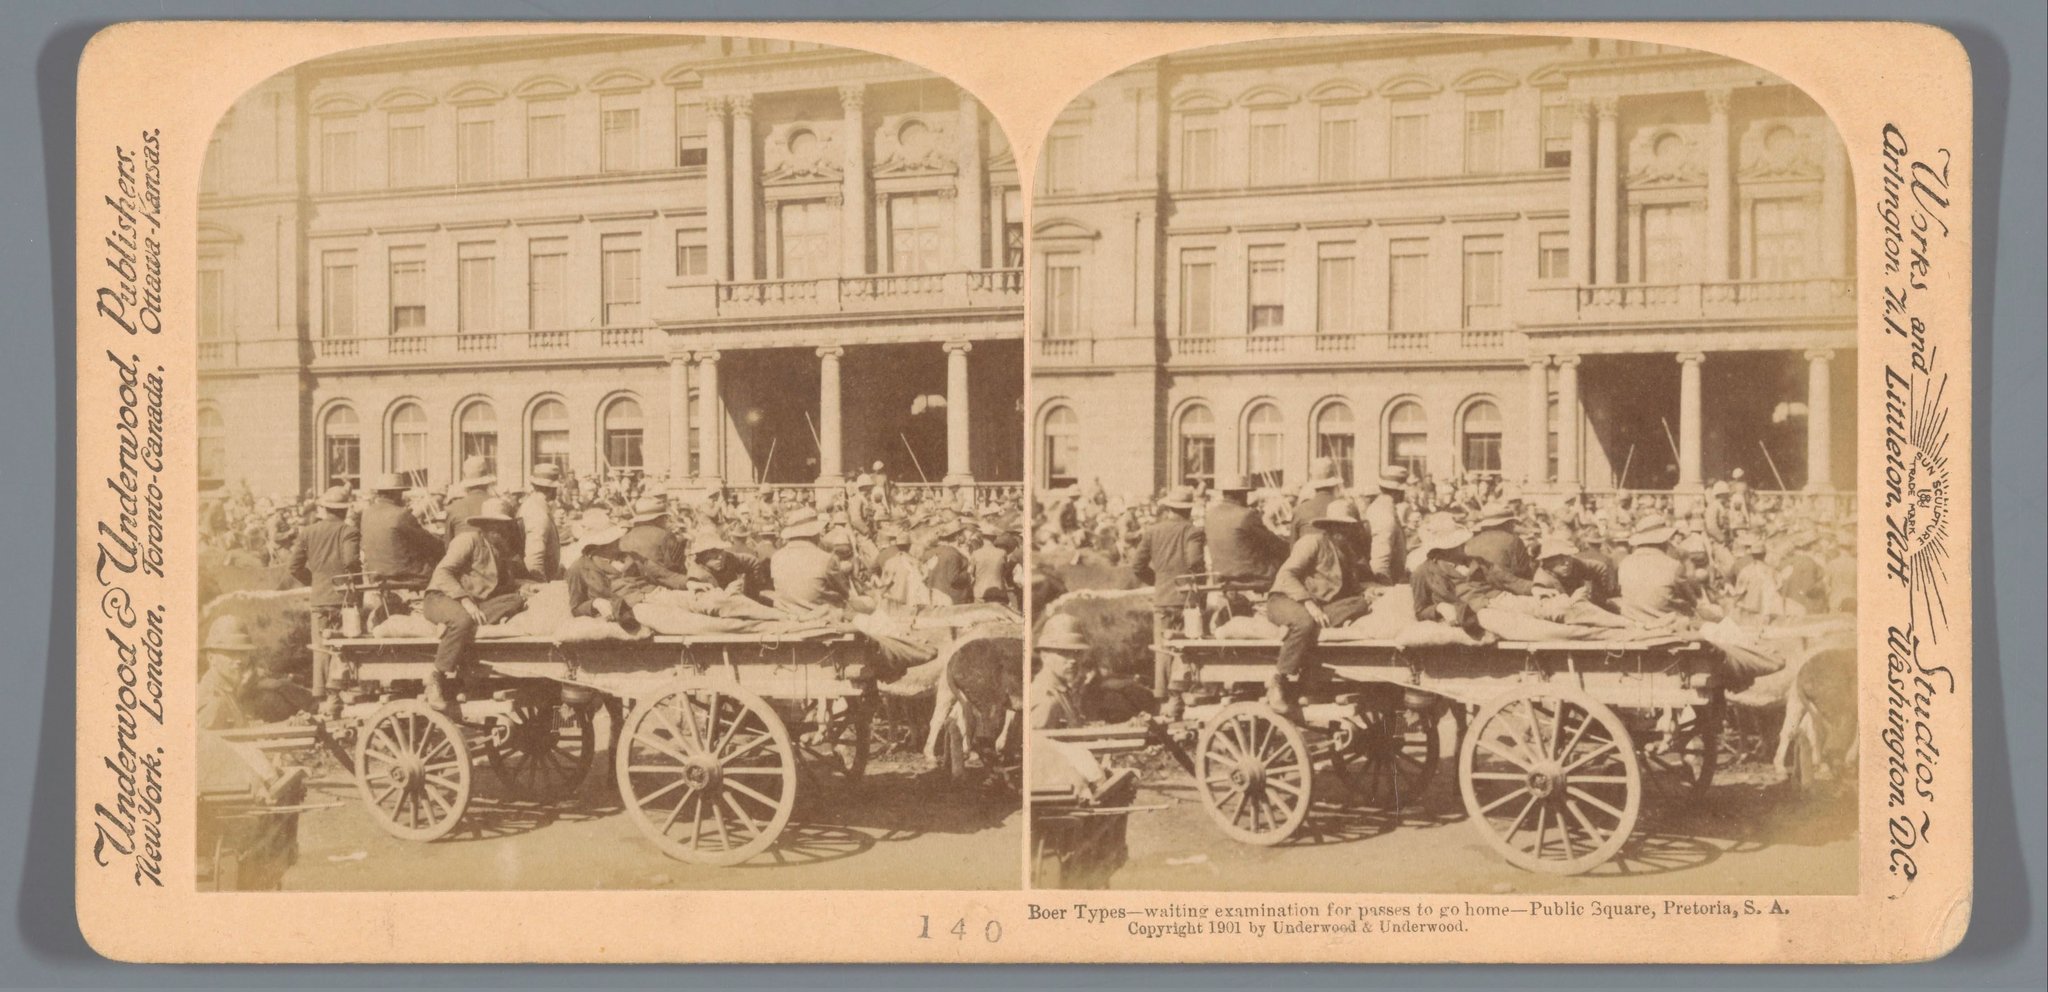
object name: stereograph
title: Boer types - waiting examination for passes to go home, Public Square, Pretoria, South Africa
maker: Anonymous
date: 1901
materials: cardboard, paper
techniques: albumen print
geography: pretoria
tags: square, place, circus, etc.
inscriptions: copyright notice: ‘Copyright 1901 by Underwood & Underwood.’, inscription: ‘Works and Studios ~/ Arlington, N.J. Littleton, N.H. Washington, D.C.’, inscription, number: ‘140’